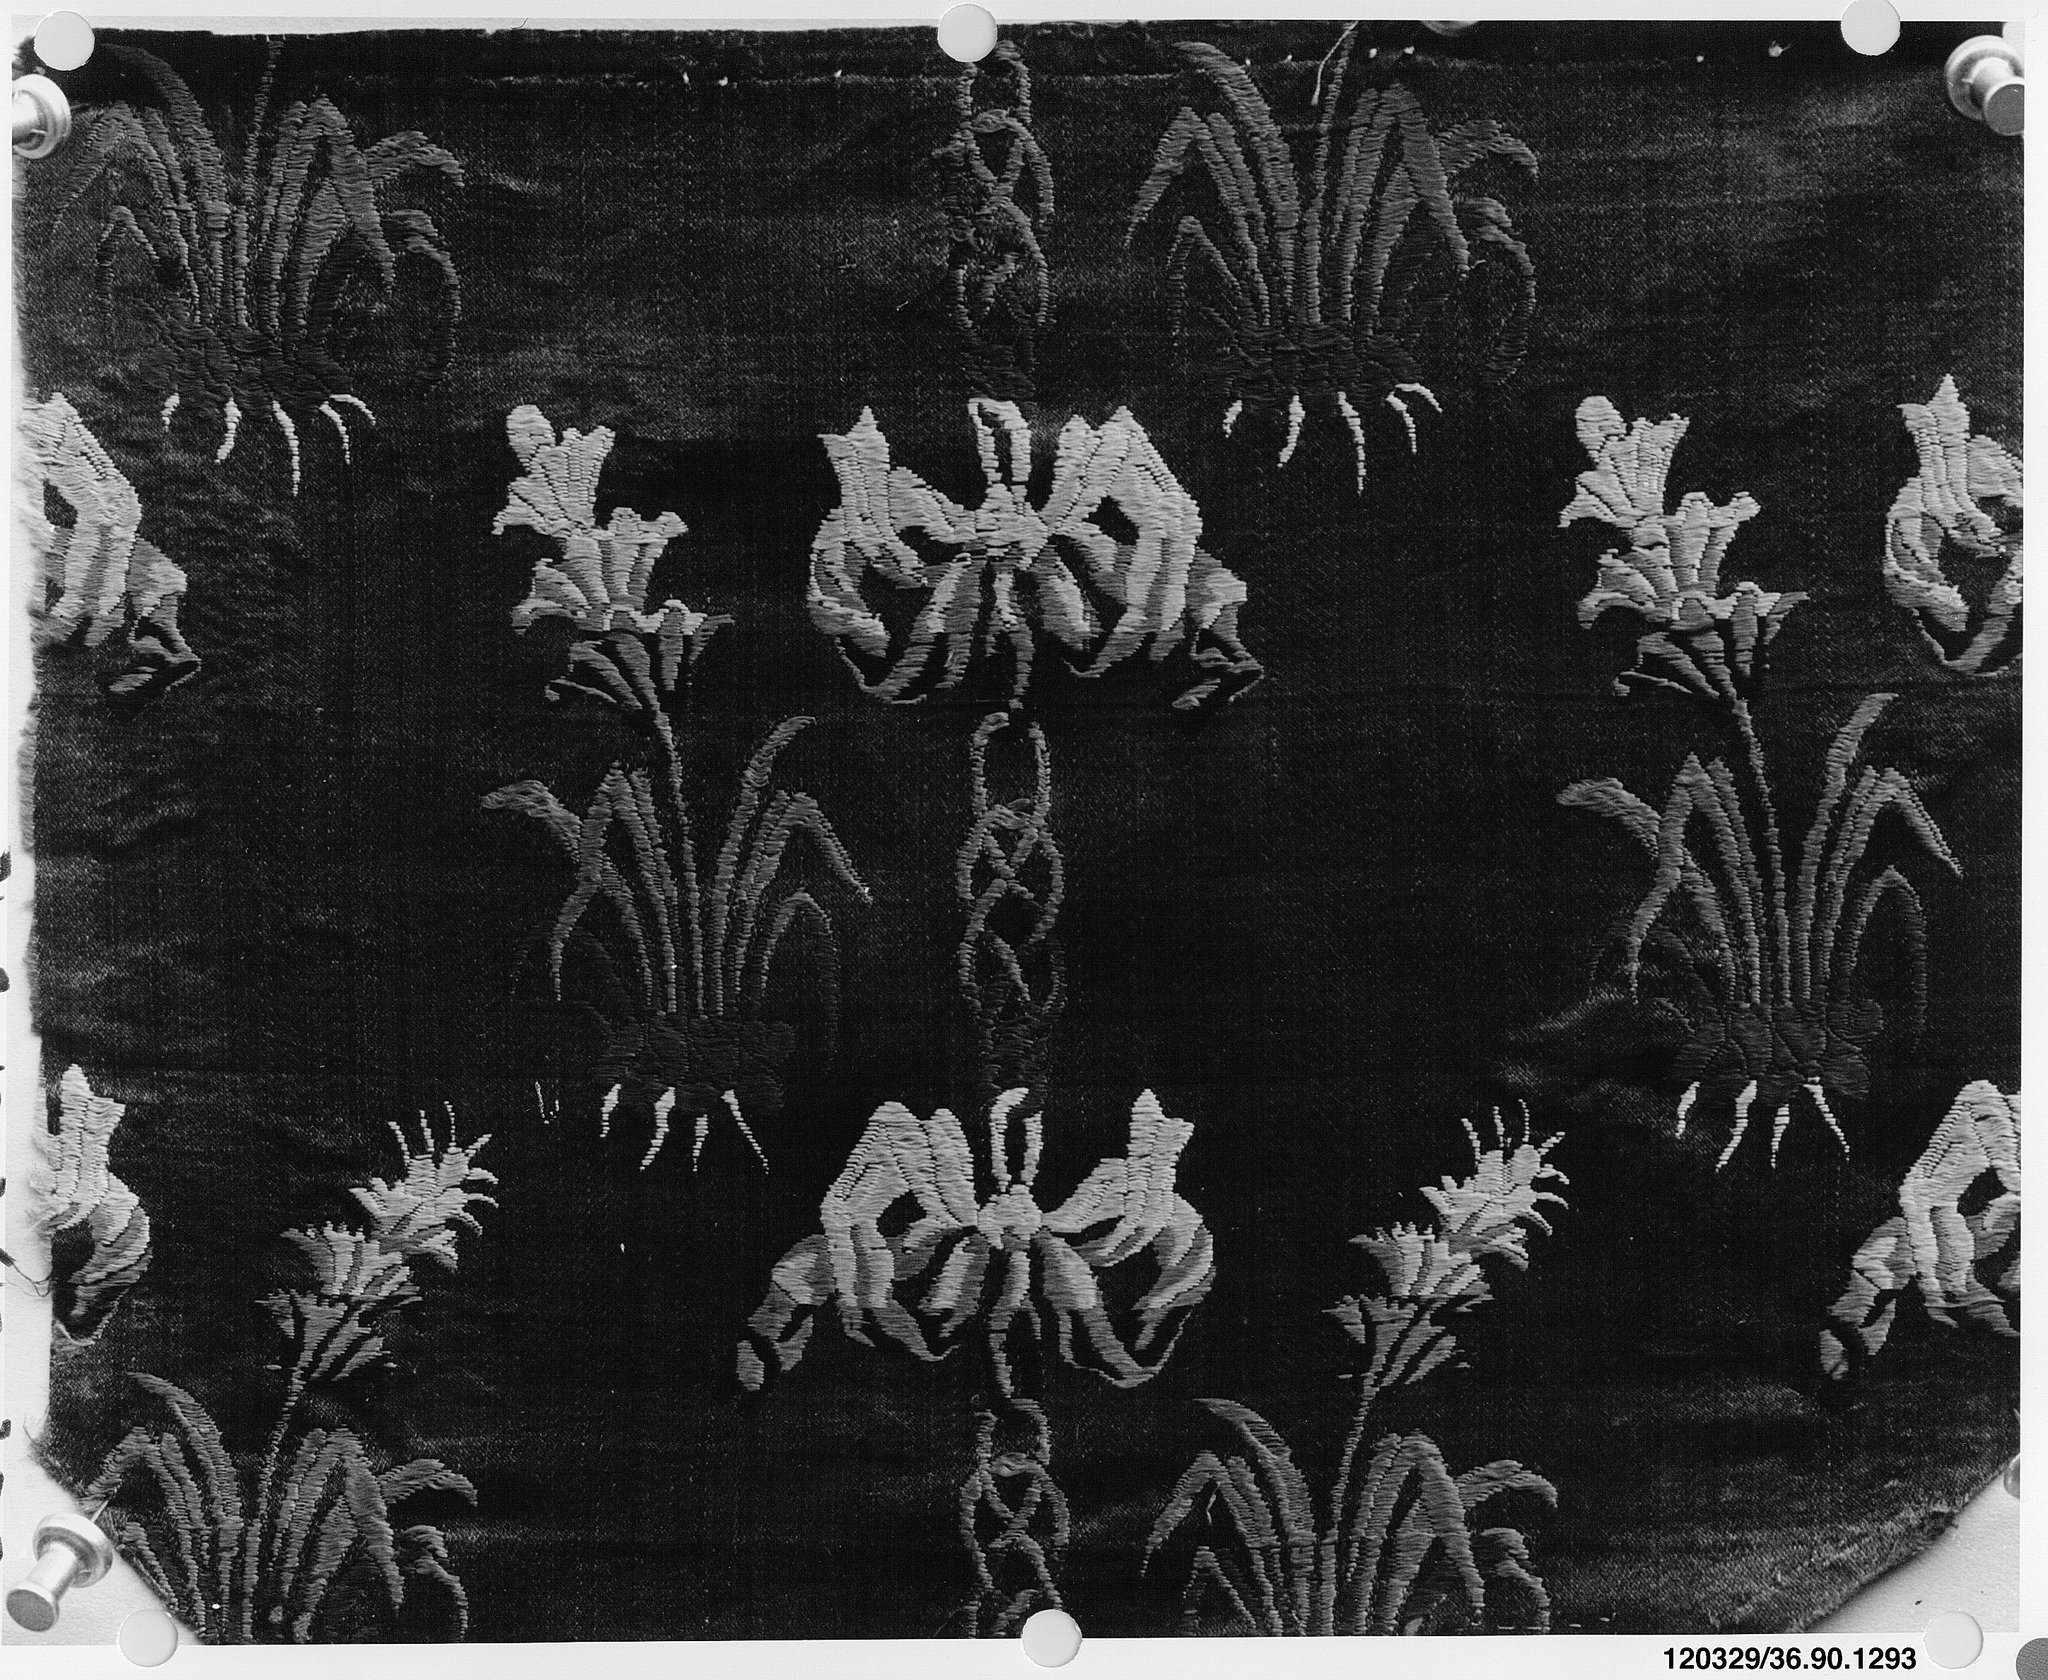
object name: piece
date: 1760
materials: silk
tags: flowers,leaves